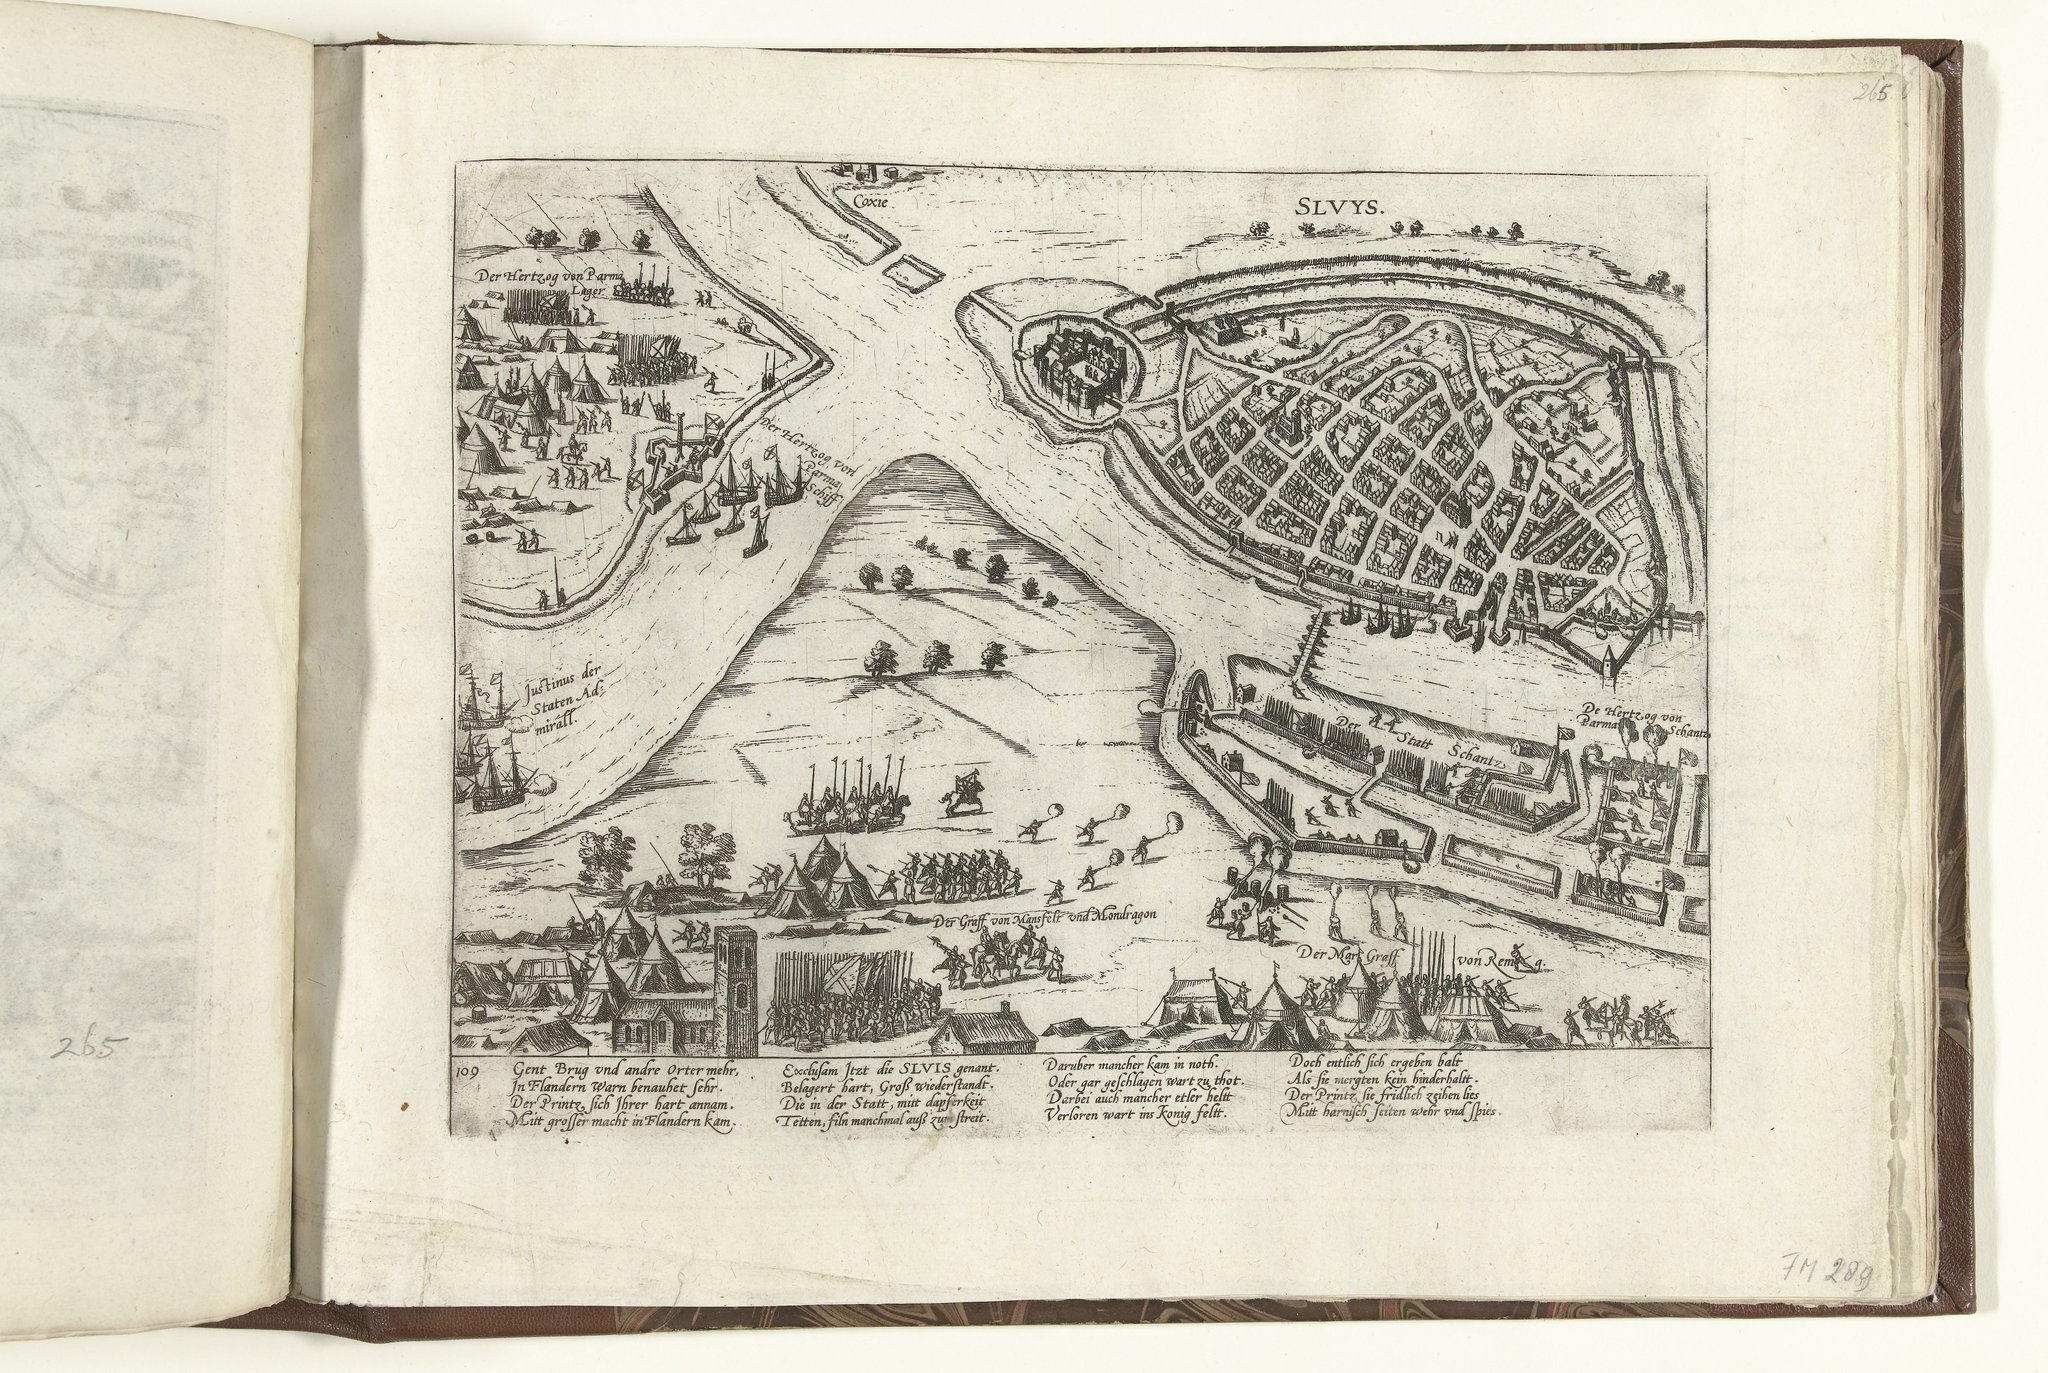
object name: album leaf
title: Verovering van Sluis door Parma, 1587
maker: frans hogenberg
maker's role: print maker, publisher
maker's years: 1538-1590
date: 1587-1589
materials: paper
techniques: etching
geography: cologne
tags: siege, position war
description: Beleg en verovering van Sluis door het leger van Parma, 5 augustus 1587. Gezicht op de stad met de legerplaatsen van het Spaanse leger. Links de toegang over het water afgesloten door schepen van Parma. Met onderschrift van 16 regels in het Duits. Genummerd: 109.